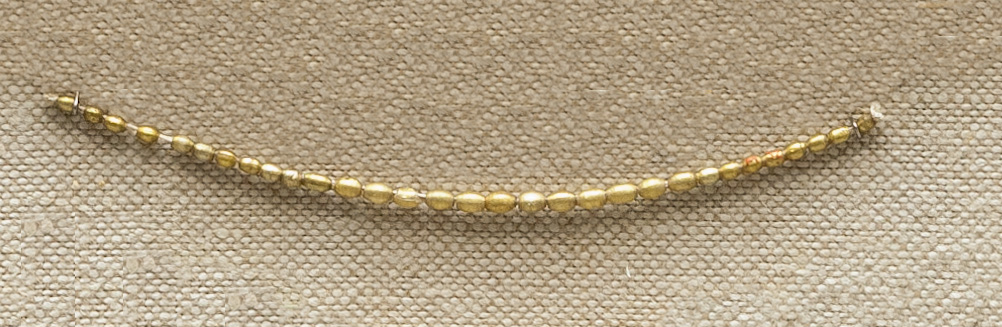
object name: bead, string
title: String of 31 Beads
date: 200 BCE-200 CE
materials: gilt, glass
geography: egypt